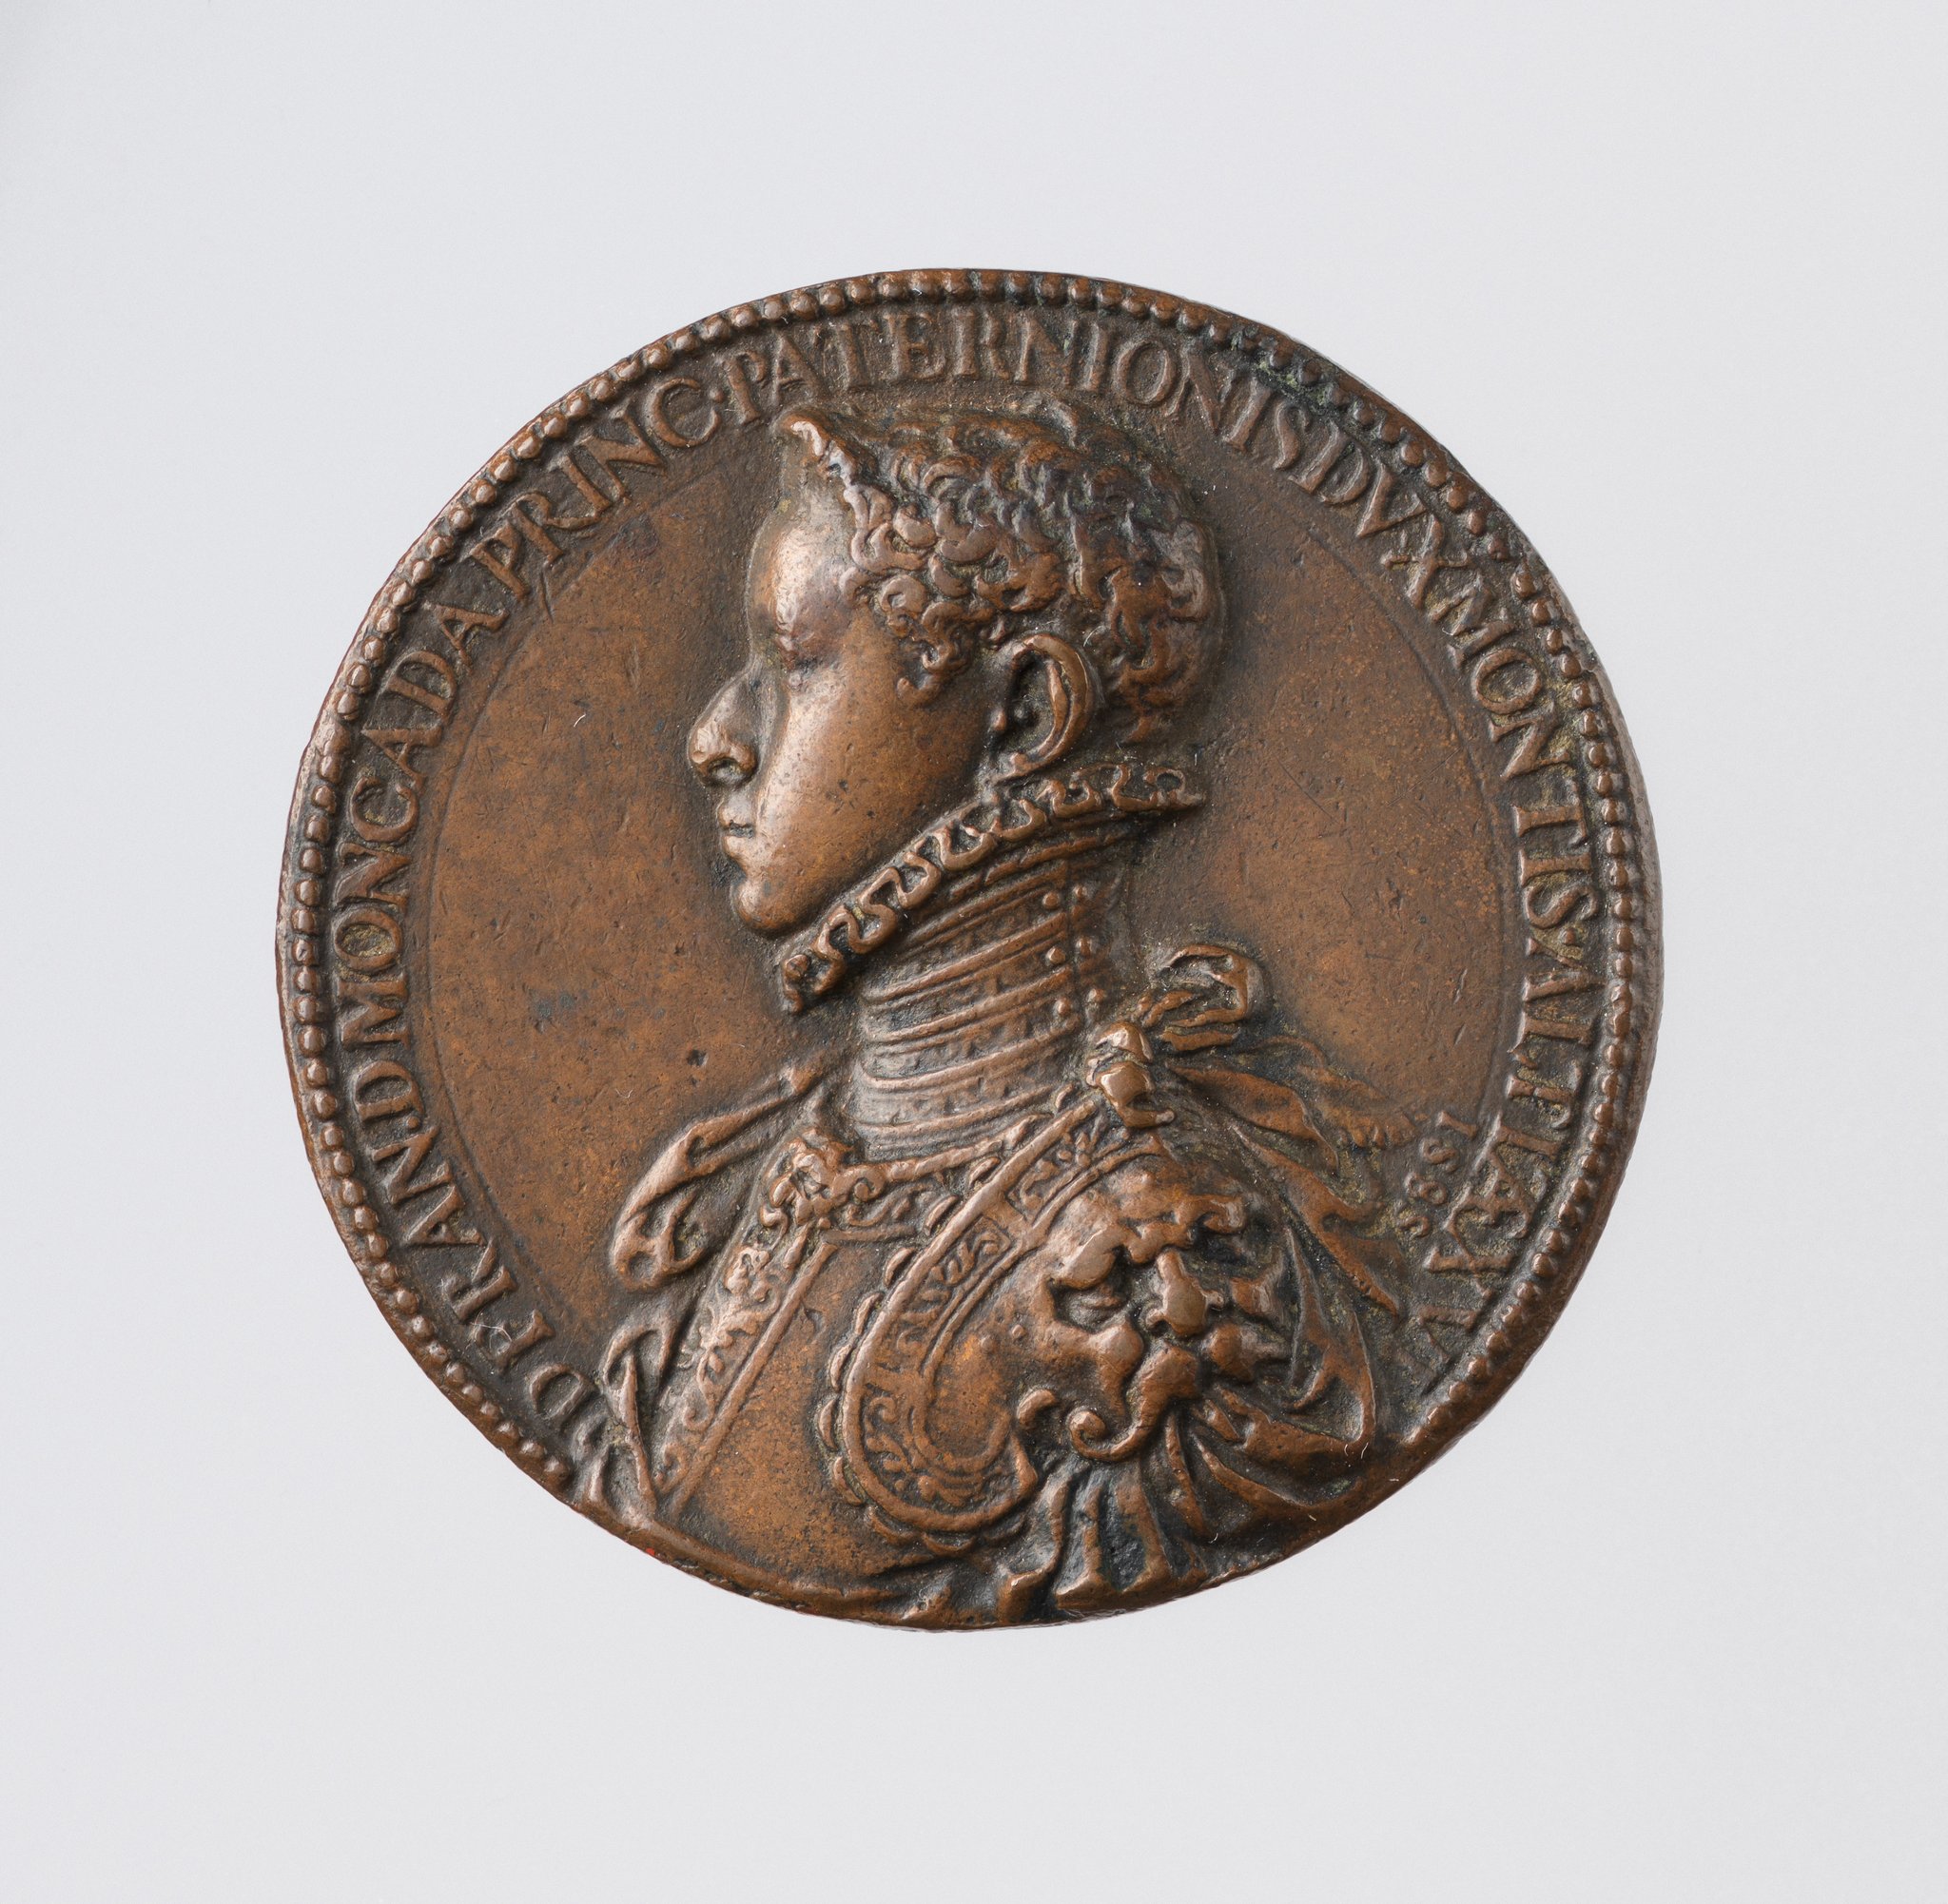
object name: medal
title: Francisco de Moncada, Duke of Montalto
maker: pompeo leoni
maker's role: artist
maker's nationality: italian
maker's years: 1533-1608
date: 1585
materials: bronze, patina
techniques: casting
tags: men,profiles